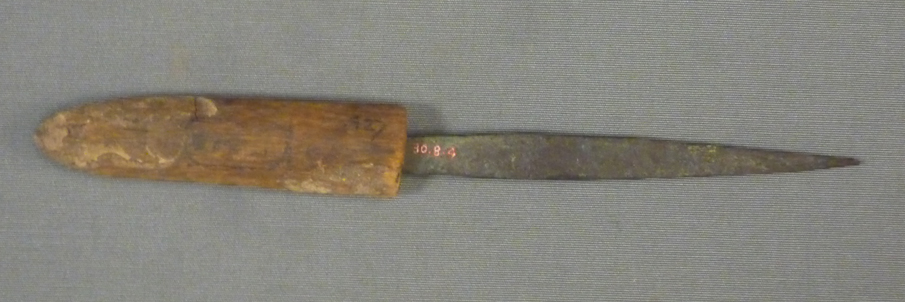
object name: model chisel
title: Model Chisel from the Foundation Deposit for Hatshepsut's Tomb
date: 1479-1458 BCE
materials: bronze, copper alloy, wood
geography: egypt